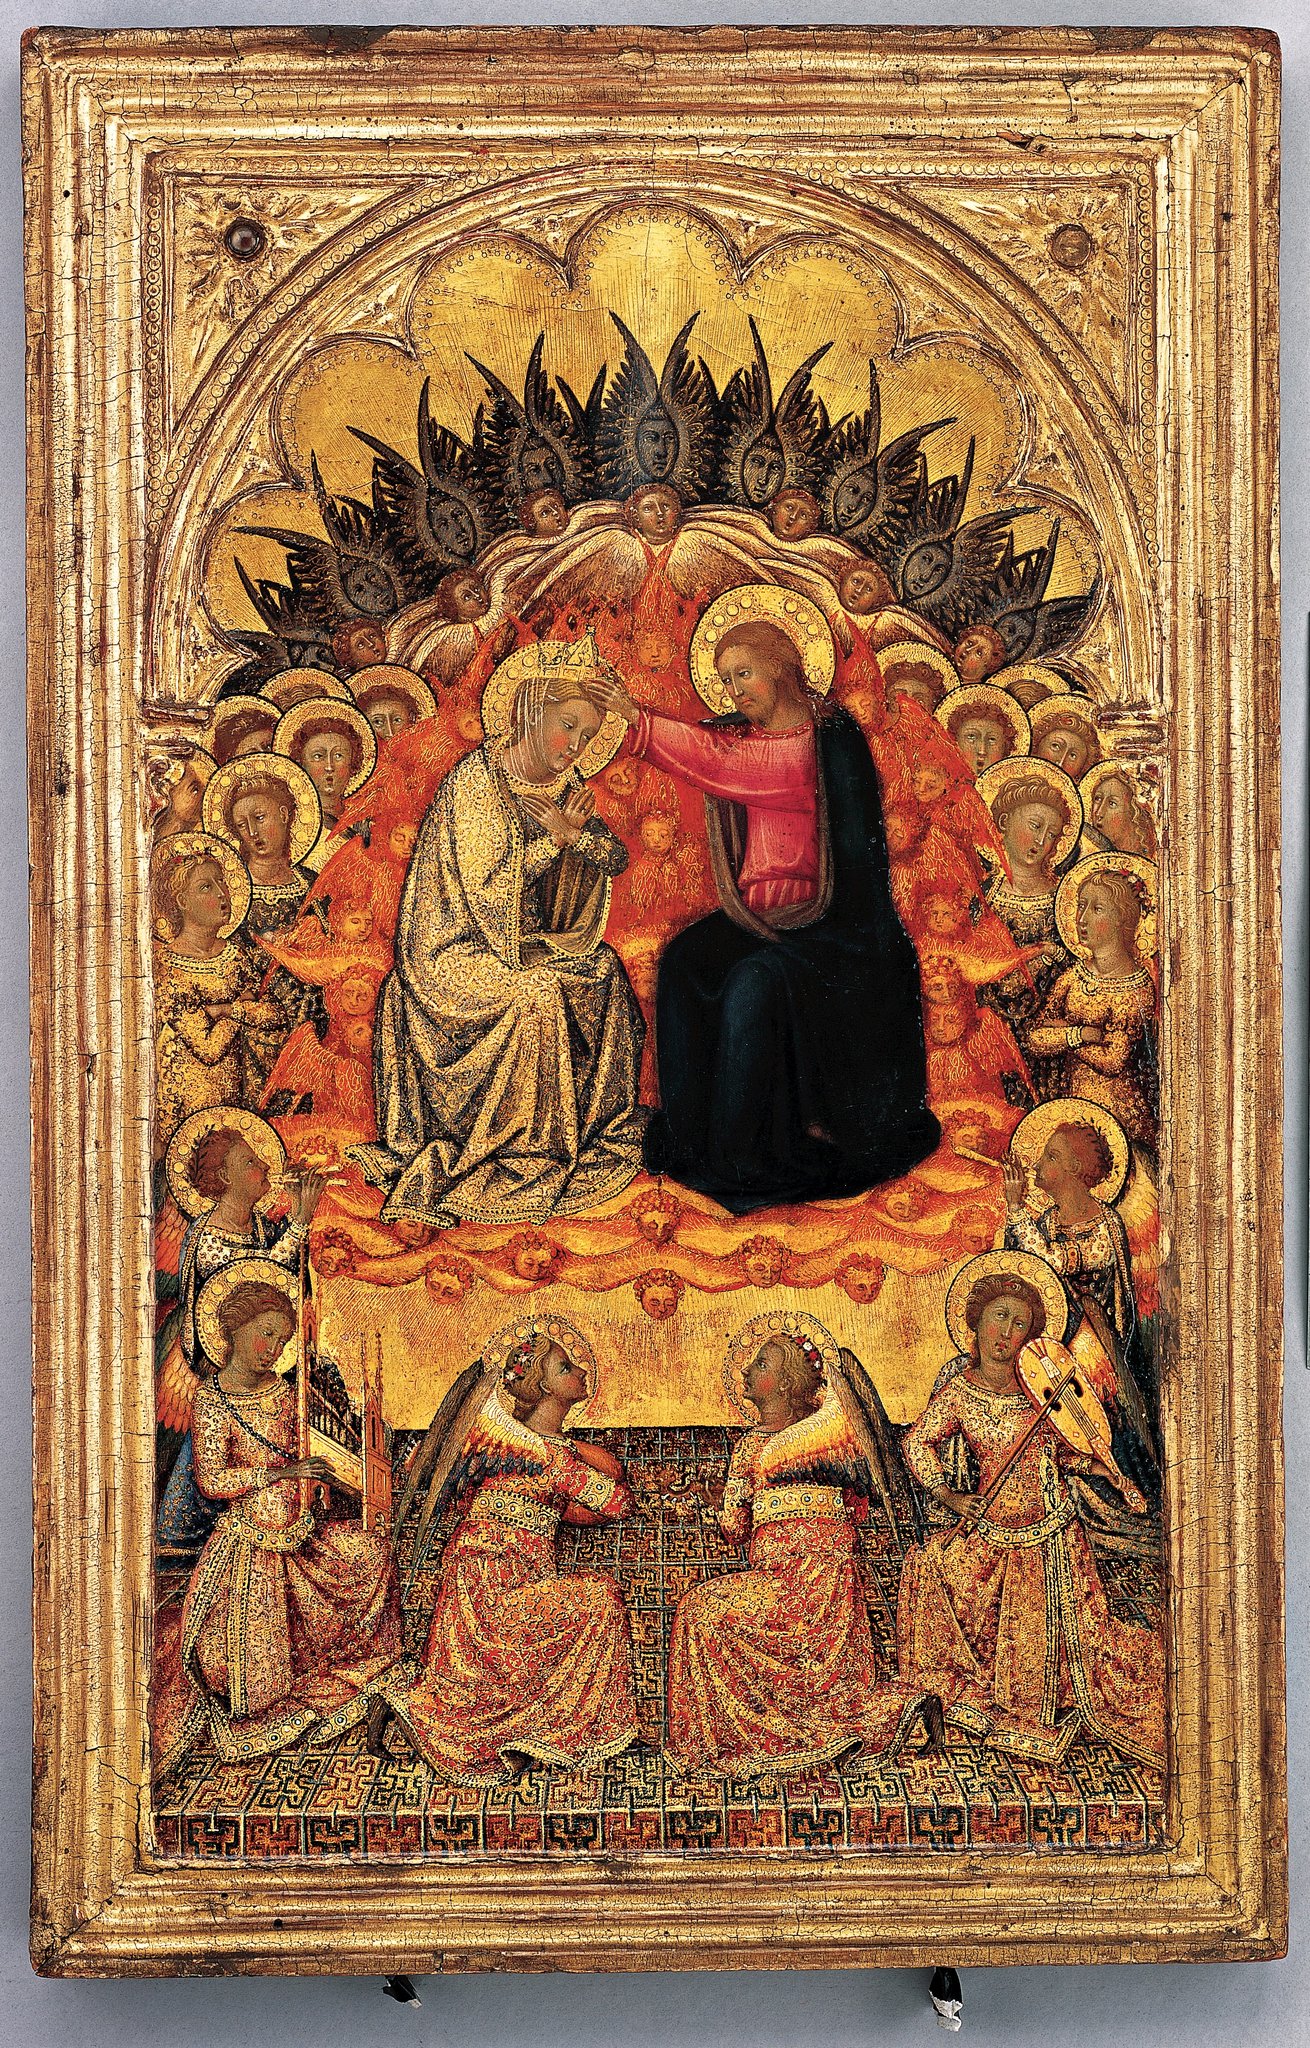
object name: frame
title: Engaged cassetta frame on a polyptych panel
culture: sienese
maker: siena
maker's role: artist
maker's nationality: siena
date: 1380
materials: gilt, wood